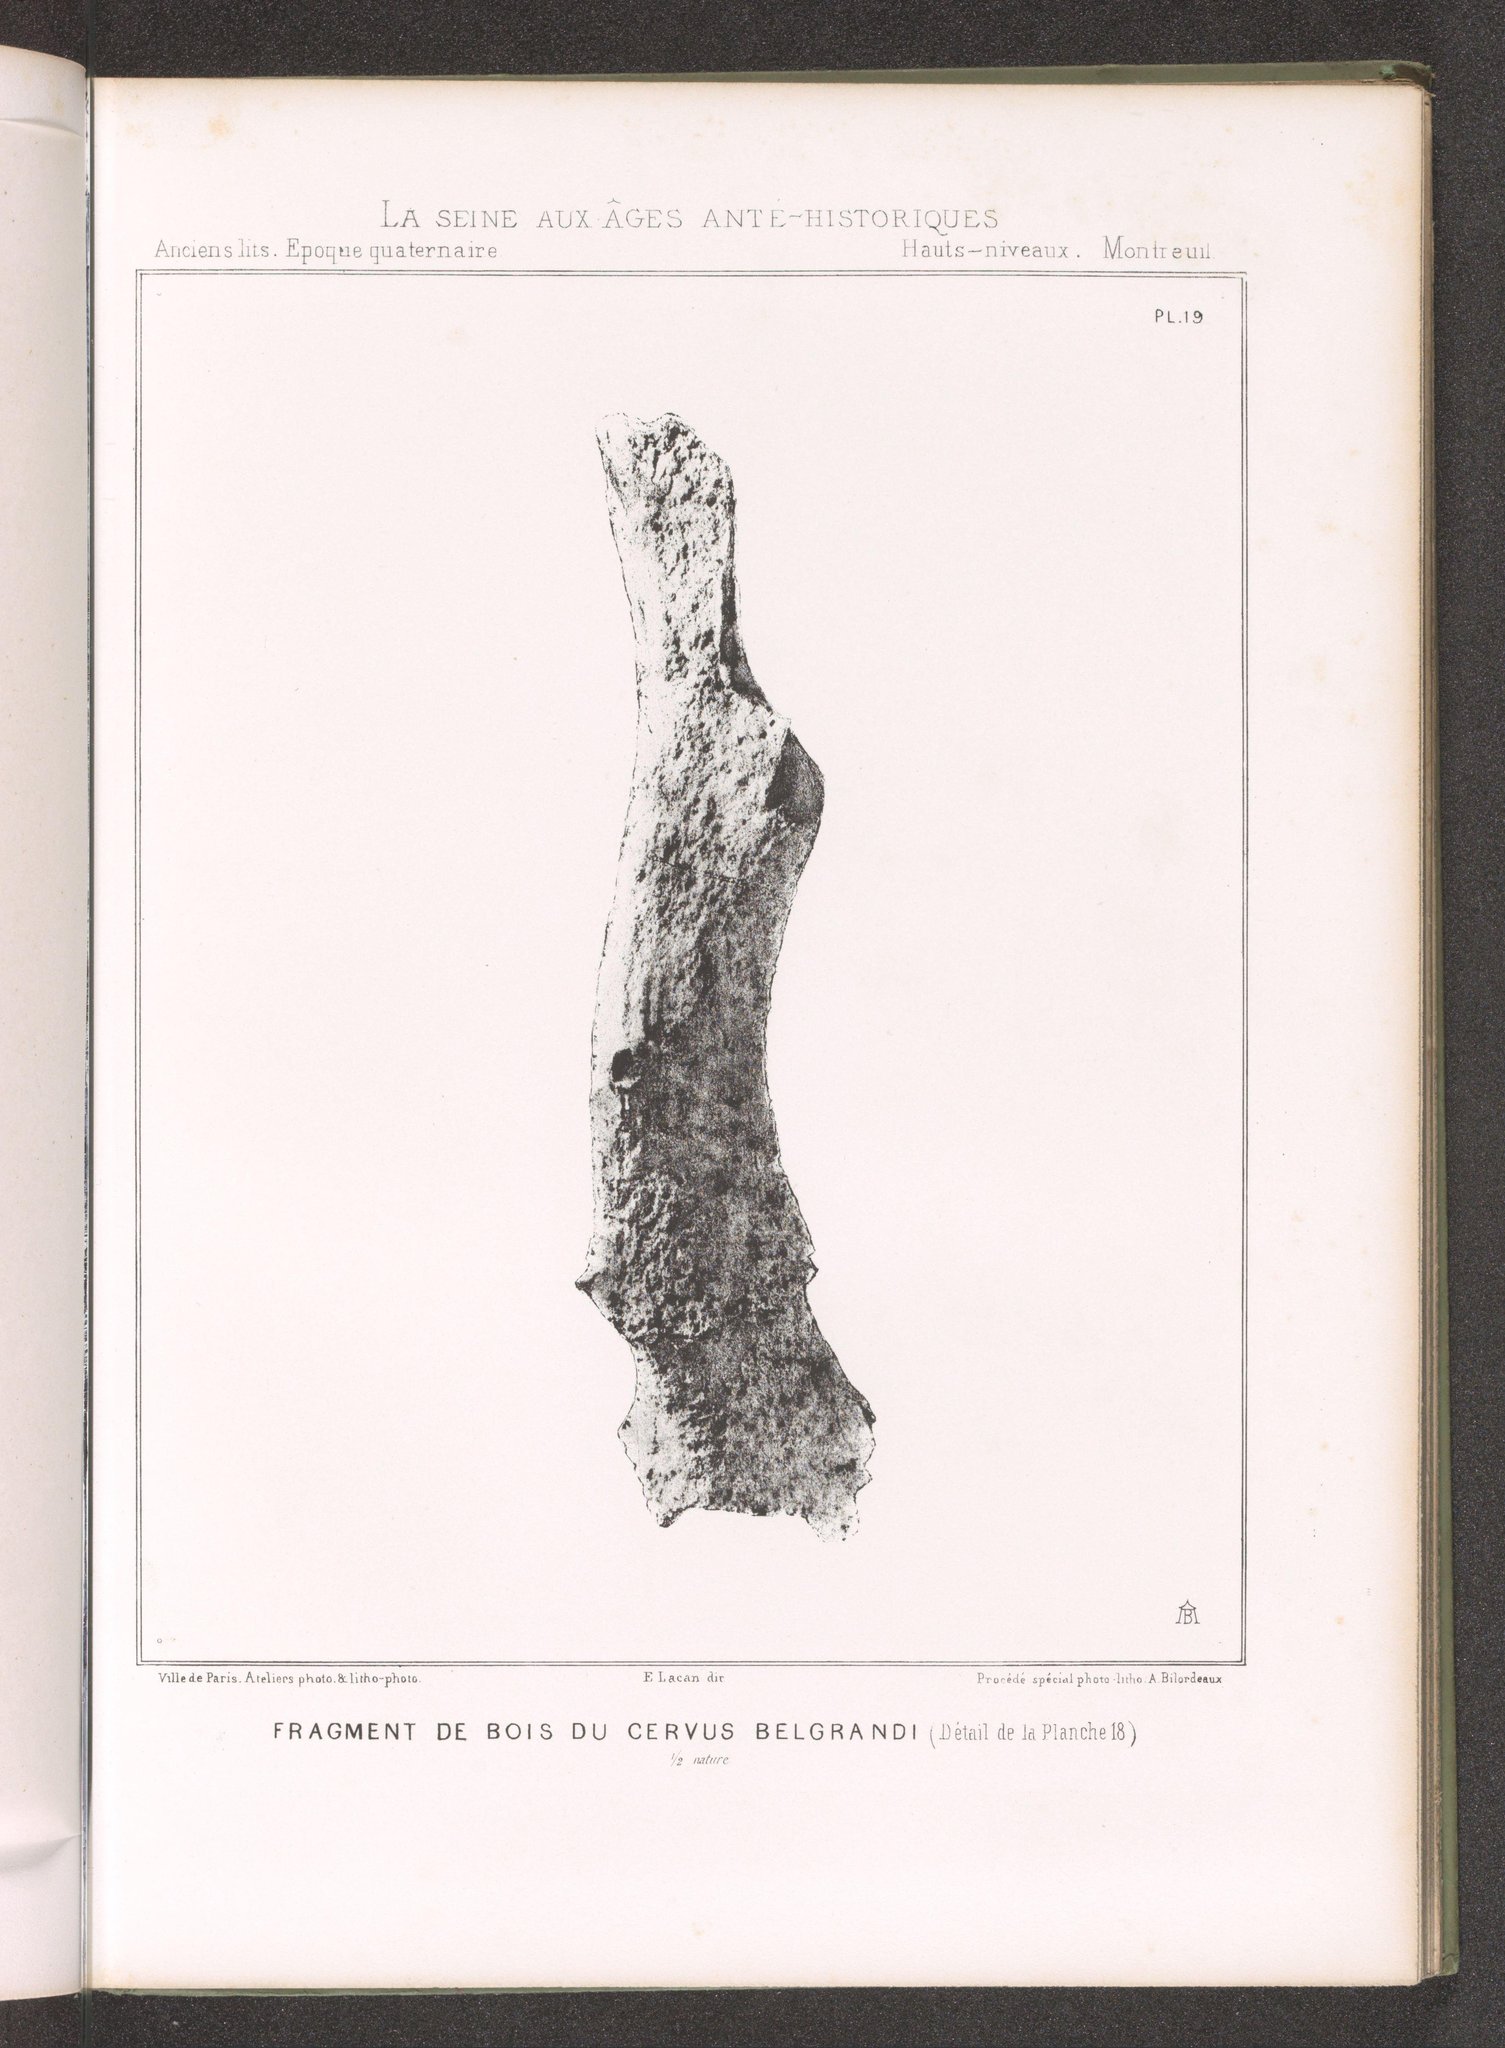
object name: photomechanical print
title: Fragment van een bot van een hert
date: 1860-1869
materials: paper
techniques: photolithography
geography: paris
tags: animals (+ skeleton of an animal), palaeontology, france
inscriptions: inscription: ‘Ville de Paris Ateliers photo & litho-photo. E. Lacan, dir. Procédé spécial photo-litho A. Bilordeaux’, monogram: ‘AB’, number: ‘Pl. 19’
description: Voor plek prent in boek: zie nummer onder 'Opschriften / Merken'.